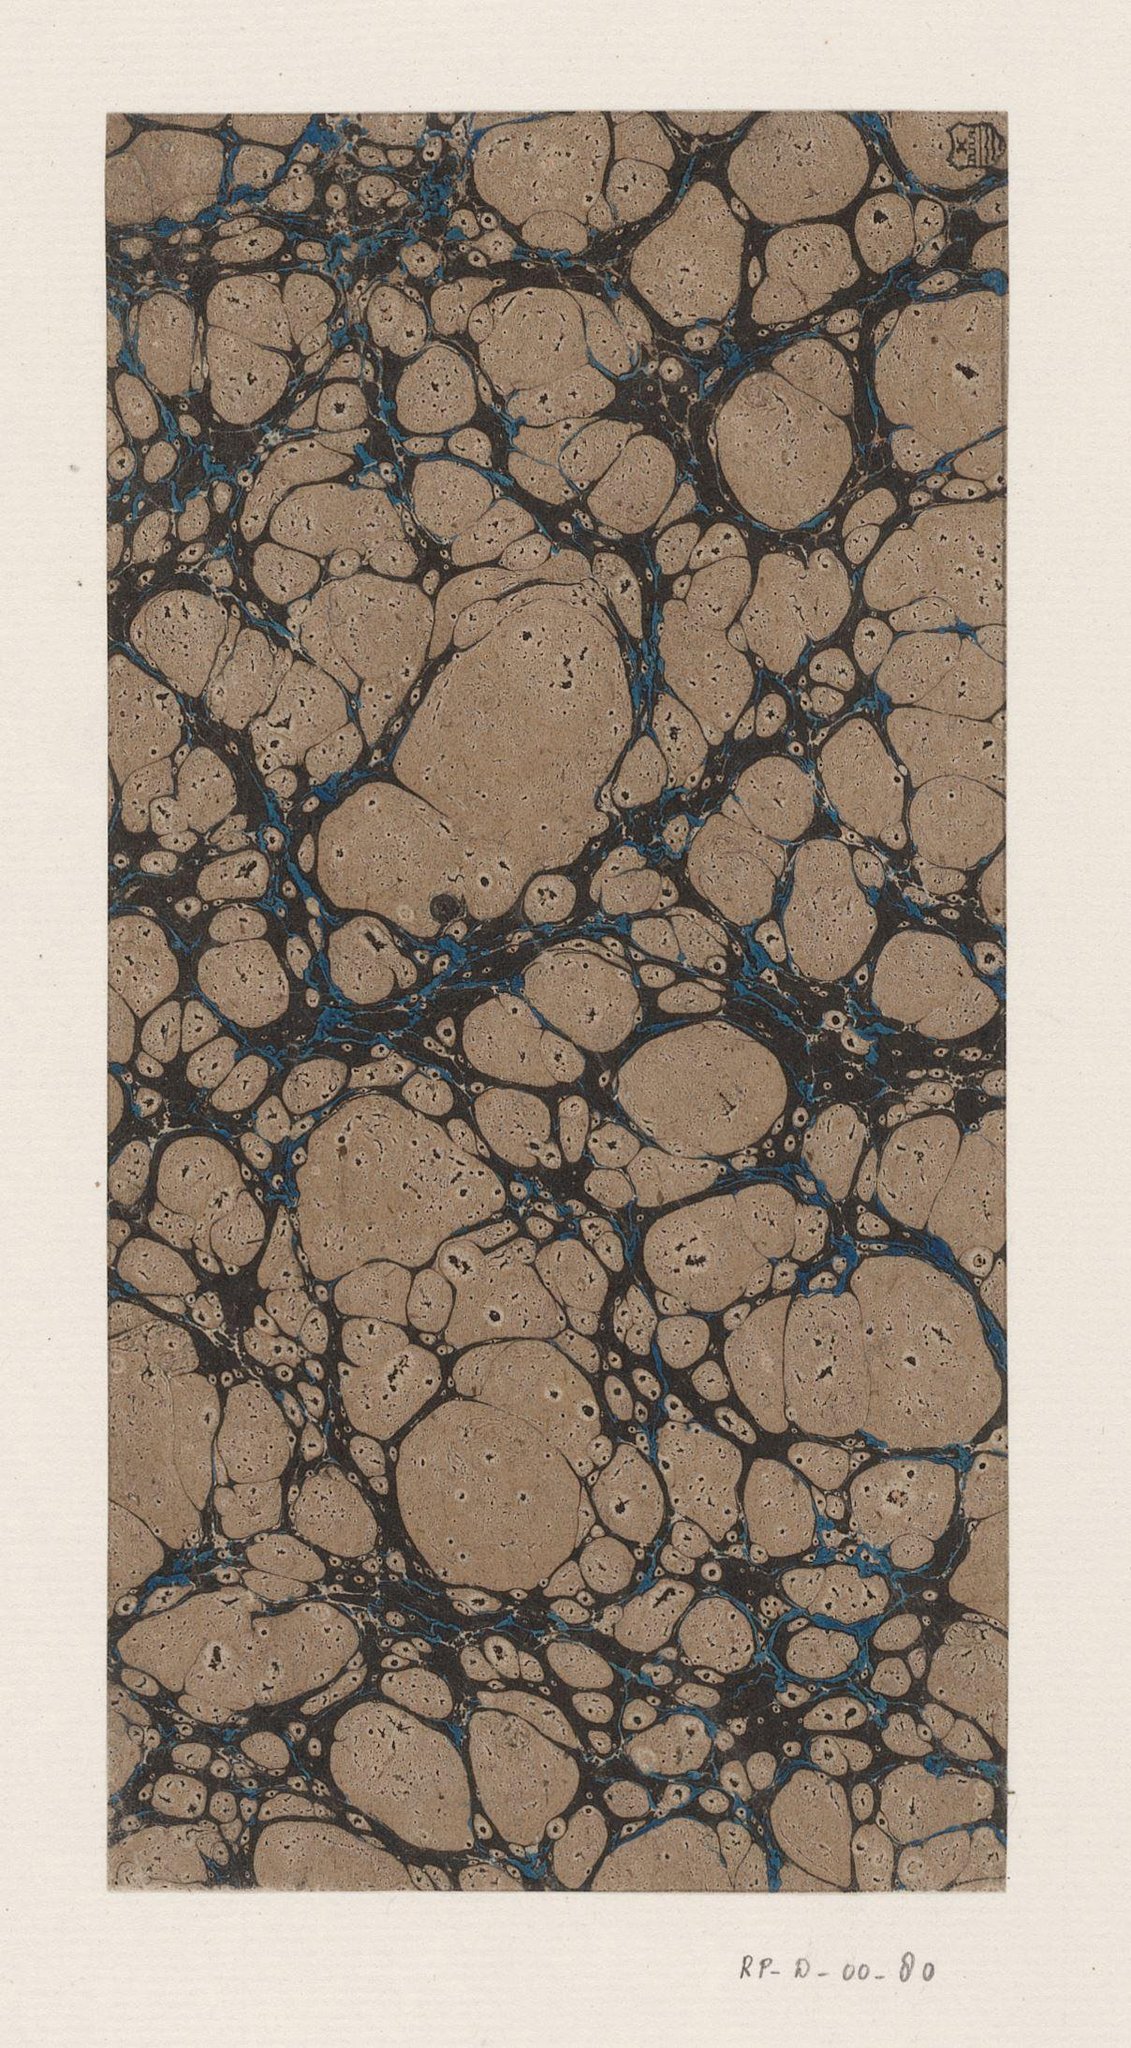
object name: marbled paper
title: Hagelmarmer in blauw, zwart en lichtbruin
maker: Anonymous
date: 1700-1850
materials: paint, paper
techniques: marbled paper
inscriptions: collector's mark: Lugt 2760